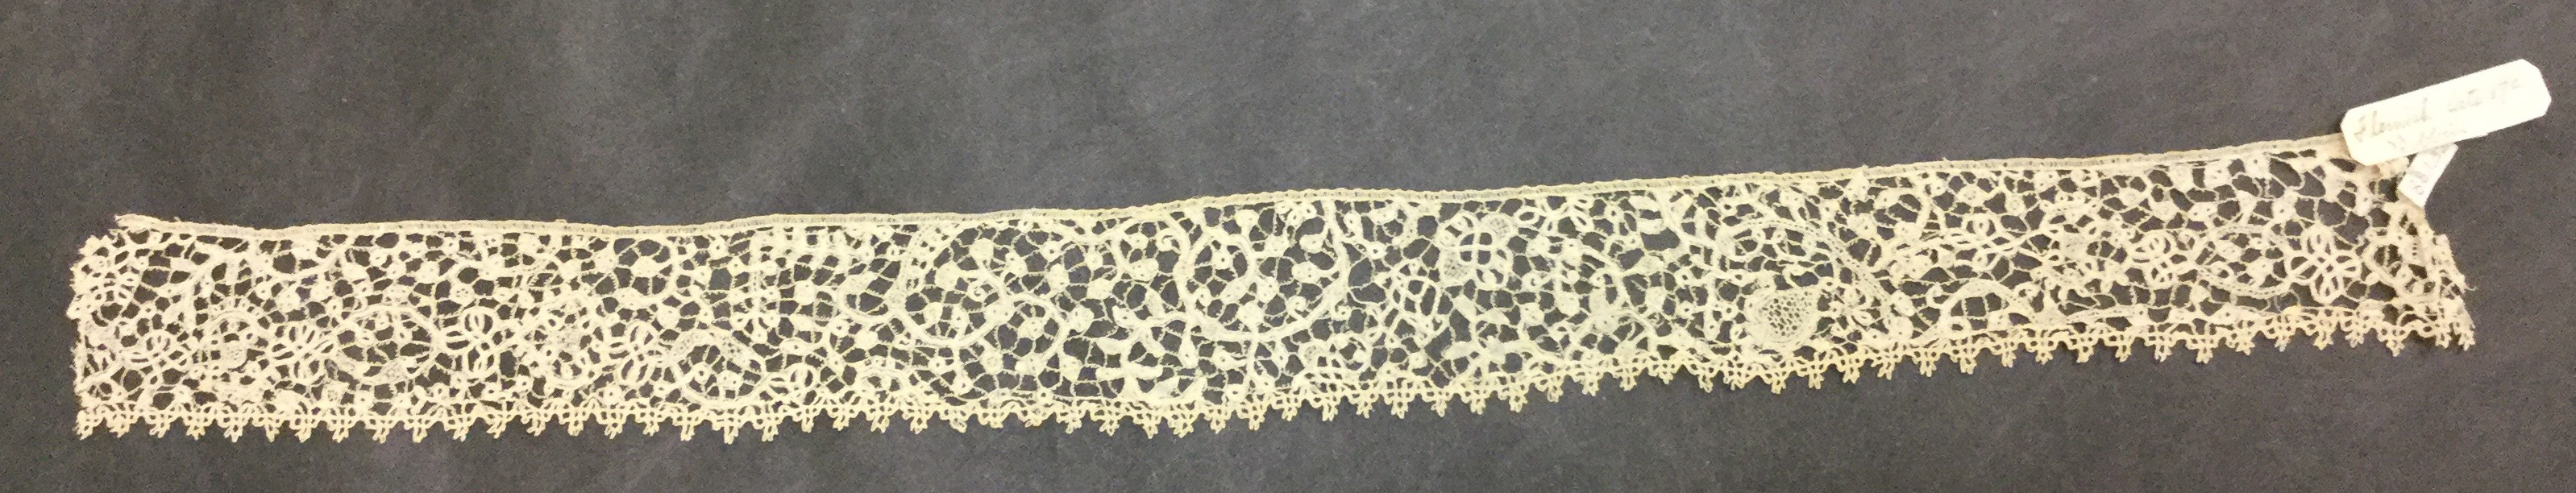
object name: fragment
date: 1667-1700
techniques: lace